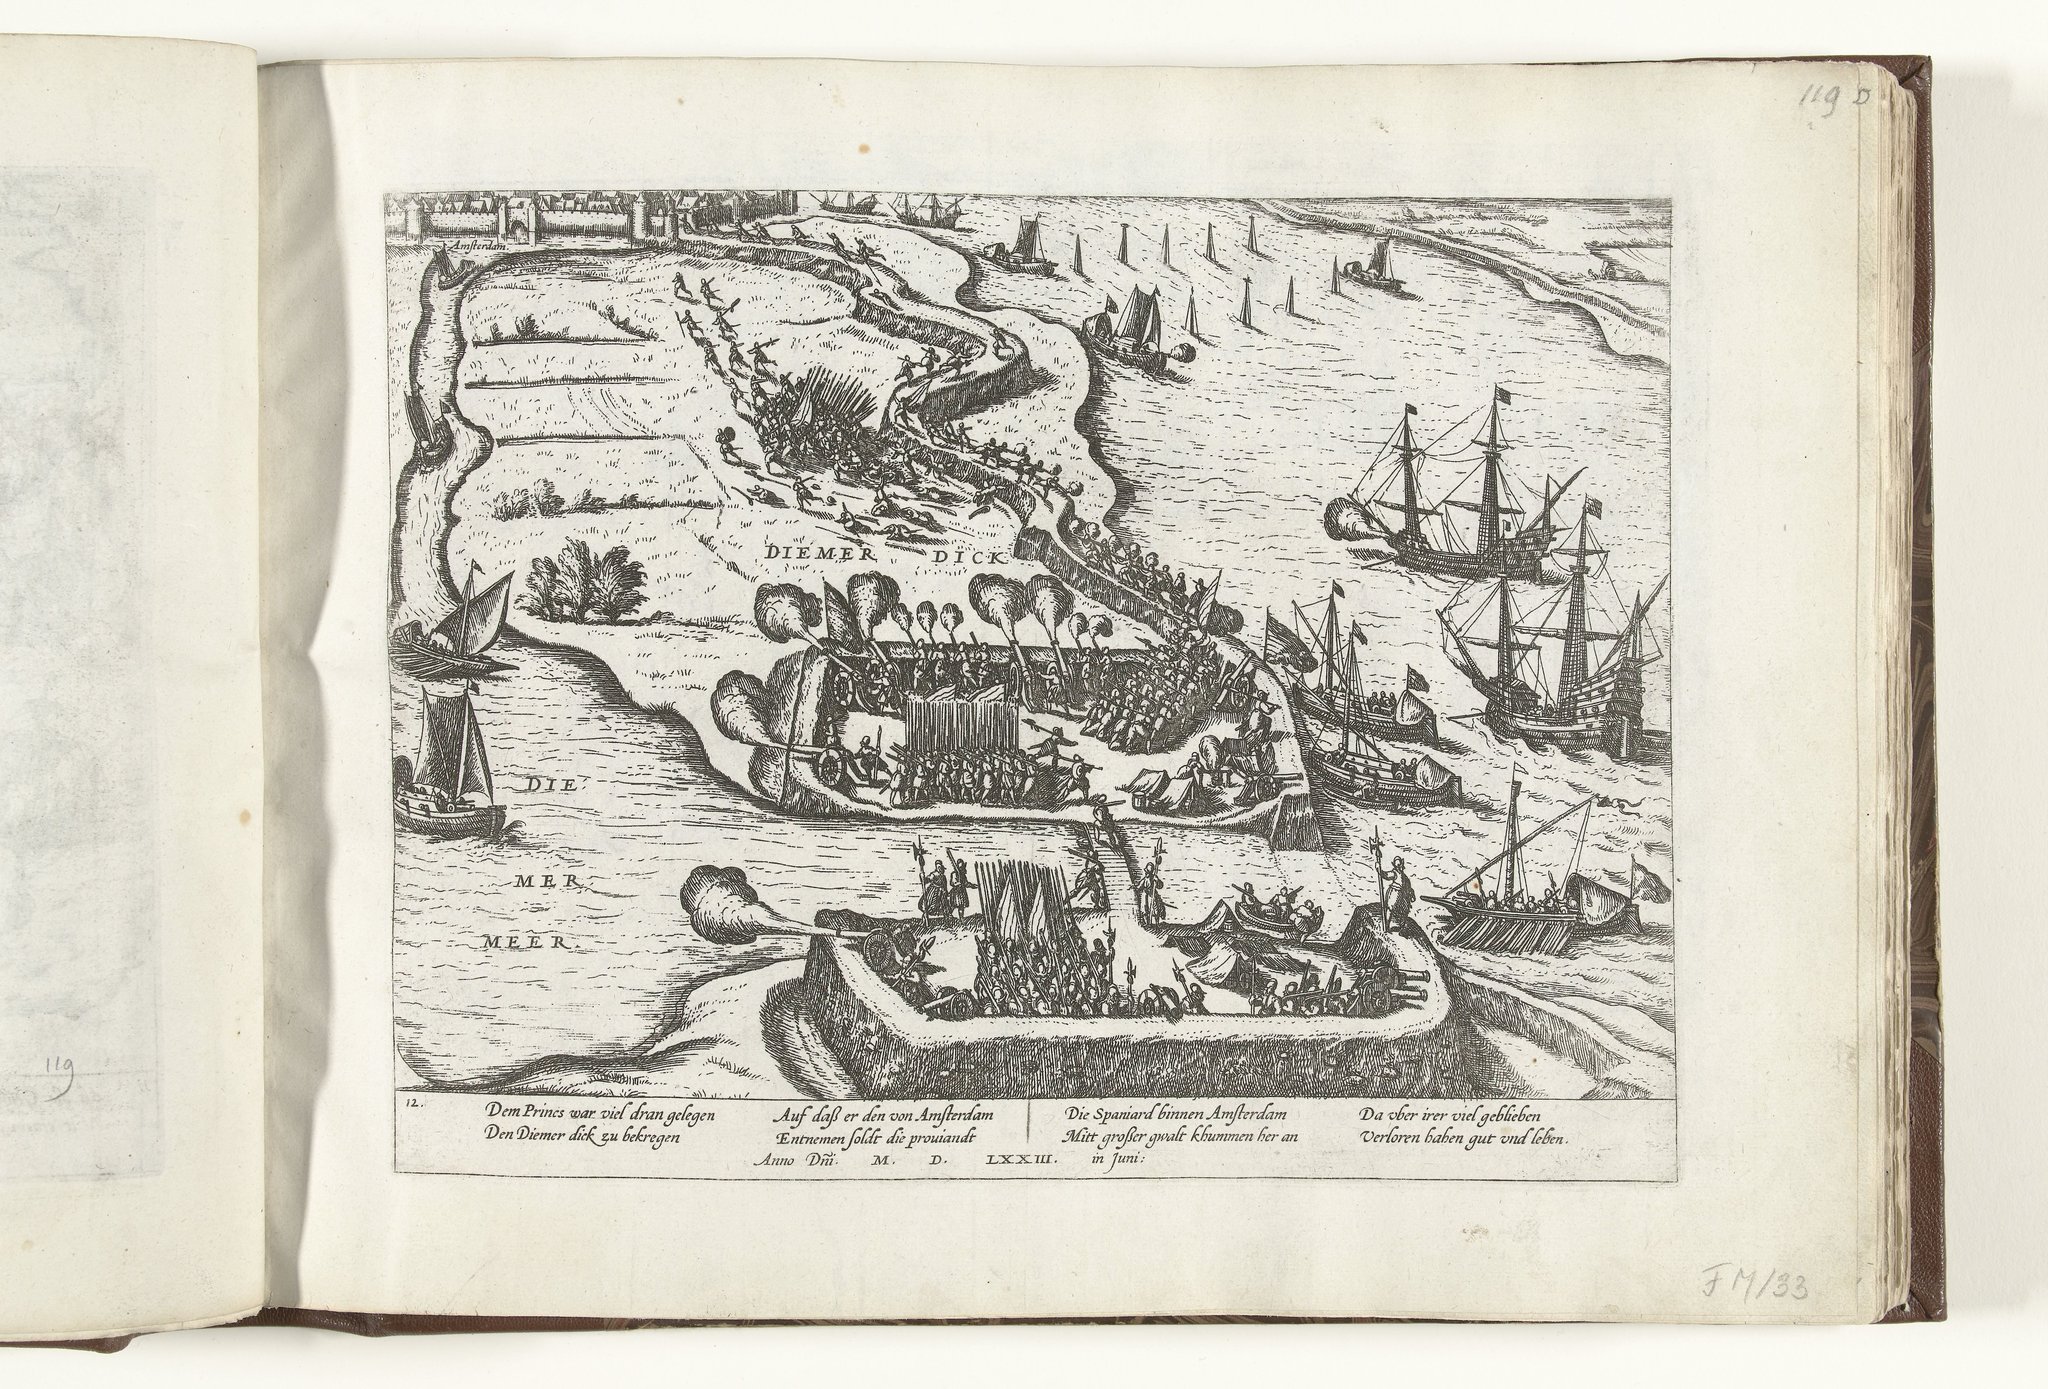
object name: print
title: Slag op de Diemerdijk, 1573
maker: frans hogenberg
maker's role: print maker, publisher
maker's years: 1538-1590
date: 1573-1575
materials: paper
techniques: etching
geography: cologne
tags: amsterdam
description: Slag op de Diemerdijk bij Amsterdam, juni 1573. De Diemerdijk door soldaten onder Sonoy op 2 juni veroverd, doorgegraven, versterkt en bezet gehouden tot 17 juli. Met onderschrift van 8 regels in het Duits. Genummerd: 12.